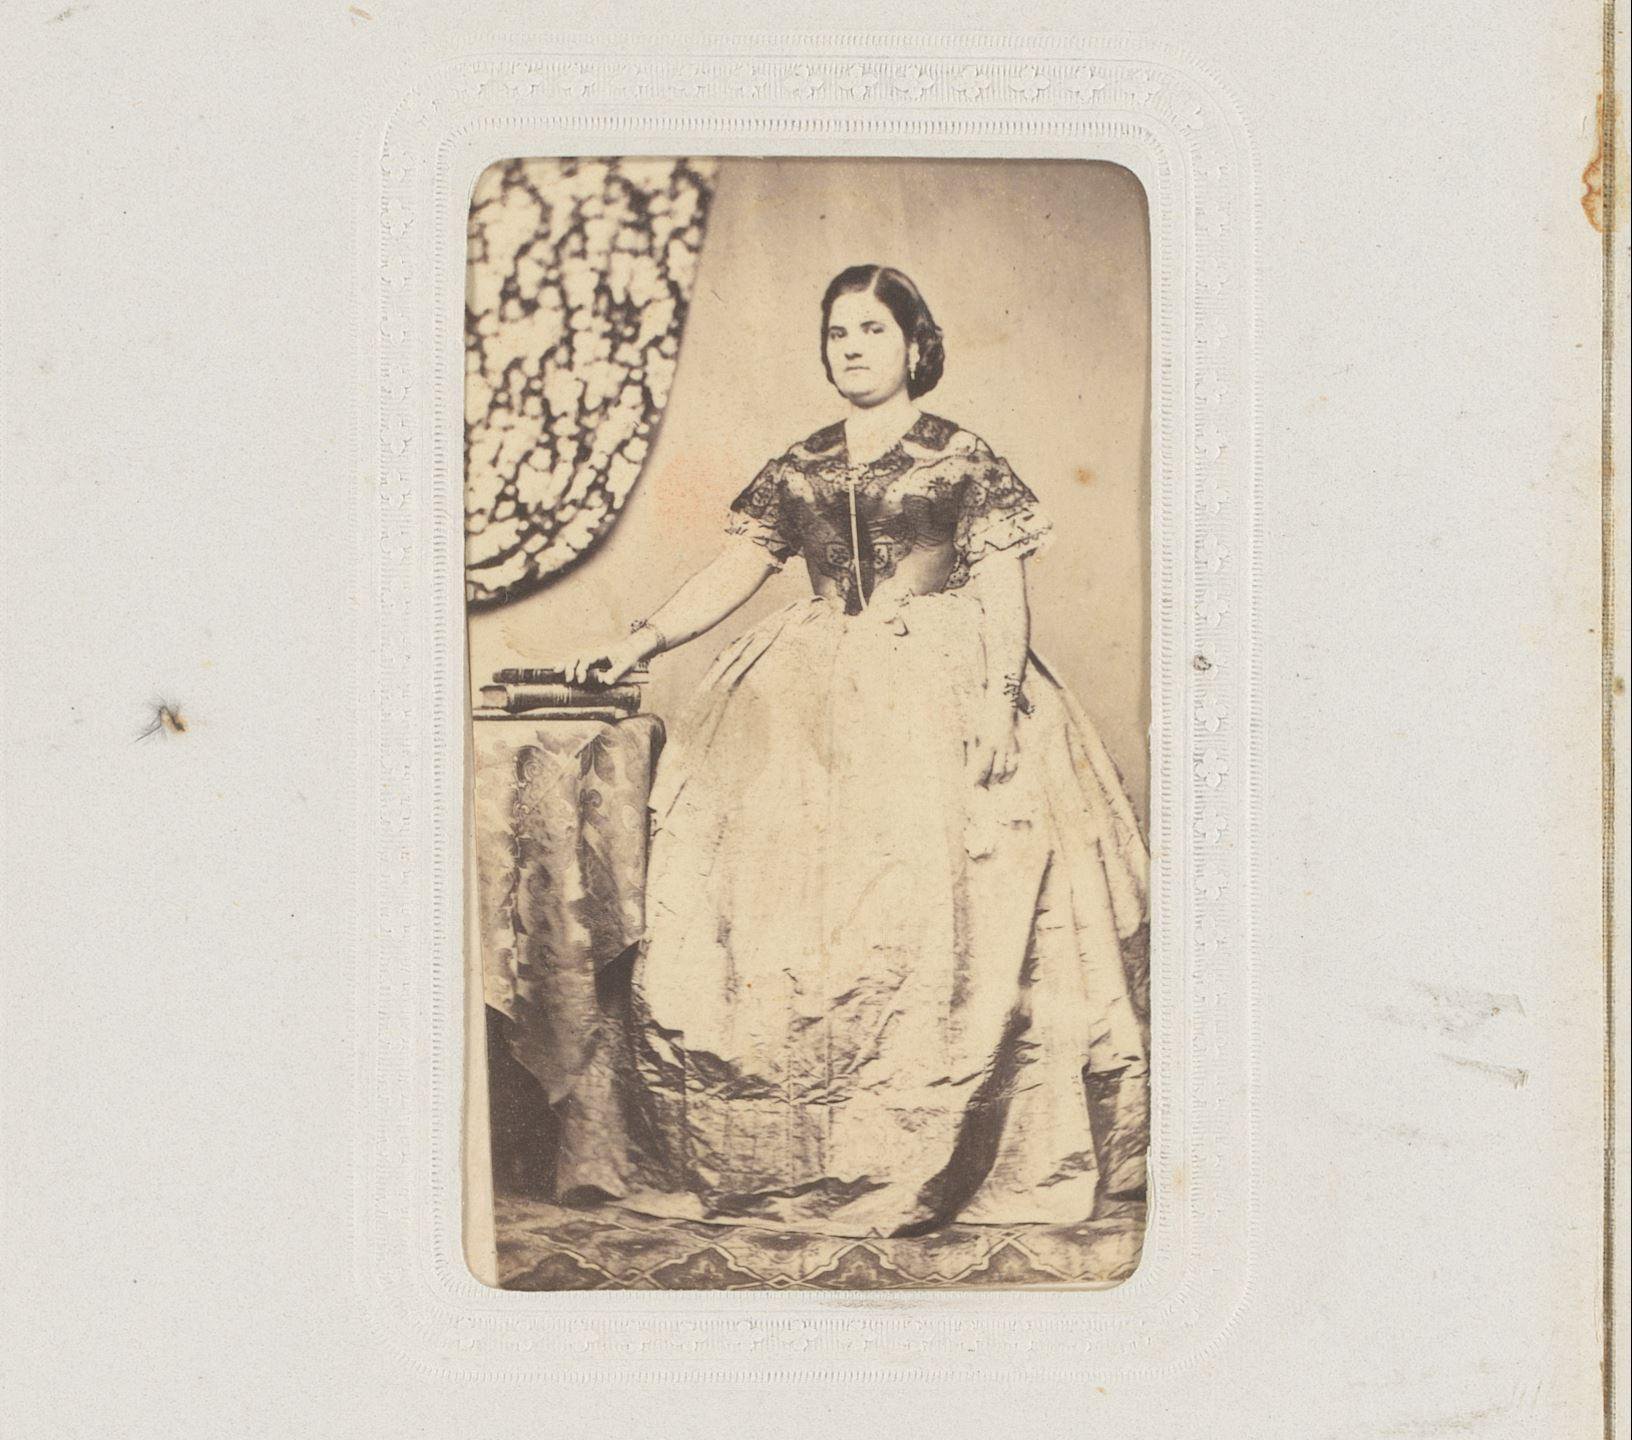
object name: photograph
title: Portret van een vrouw, staand bij een tafel met boeken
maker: Anonymous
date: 1860-1890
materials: cardboard, photographic support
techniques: albumen print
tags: historical persons - bb - woman, standing figure - aa - female human figure